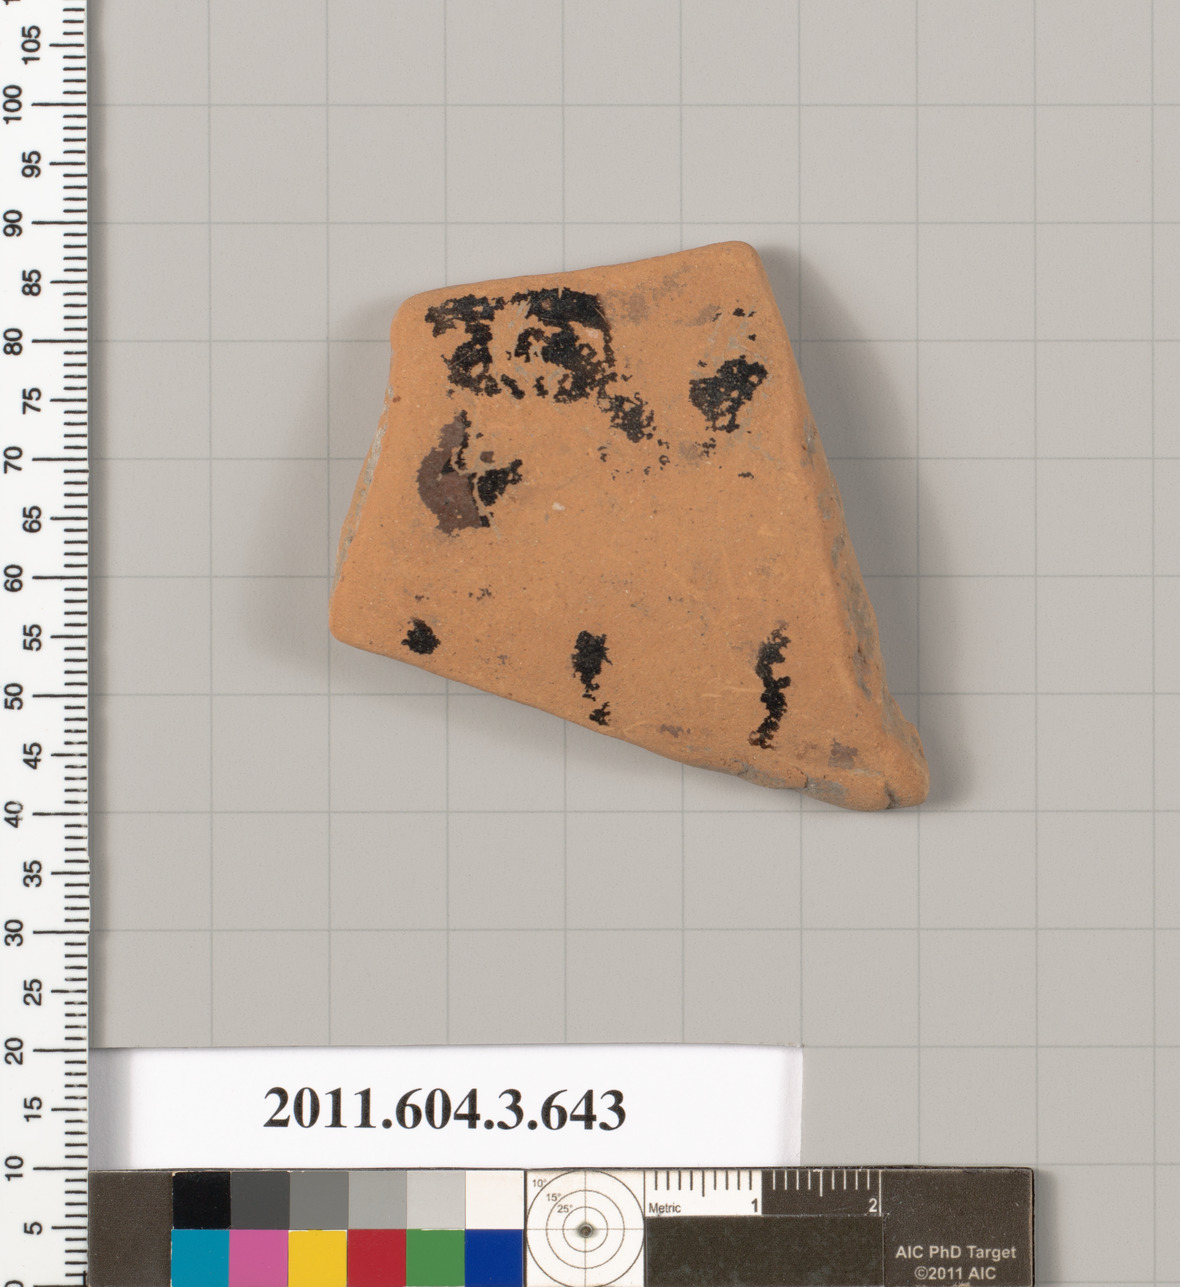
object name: column krater fragment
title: Terracotta fragment of a column-krater (bowl for mixing wine and water)?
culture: greek, attic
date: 534-468 BCE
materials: terracotta